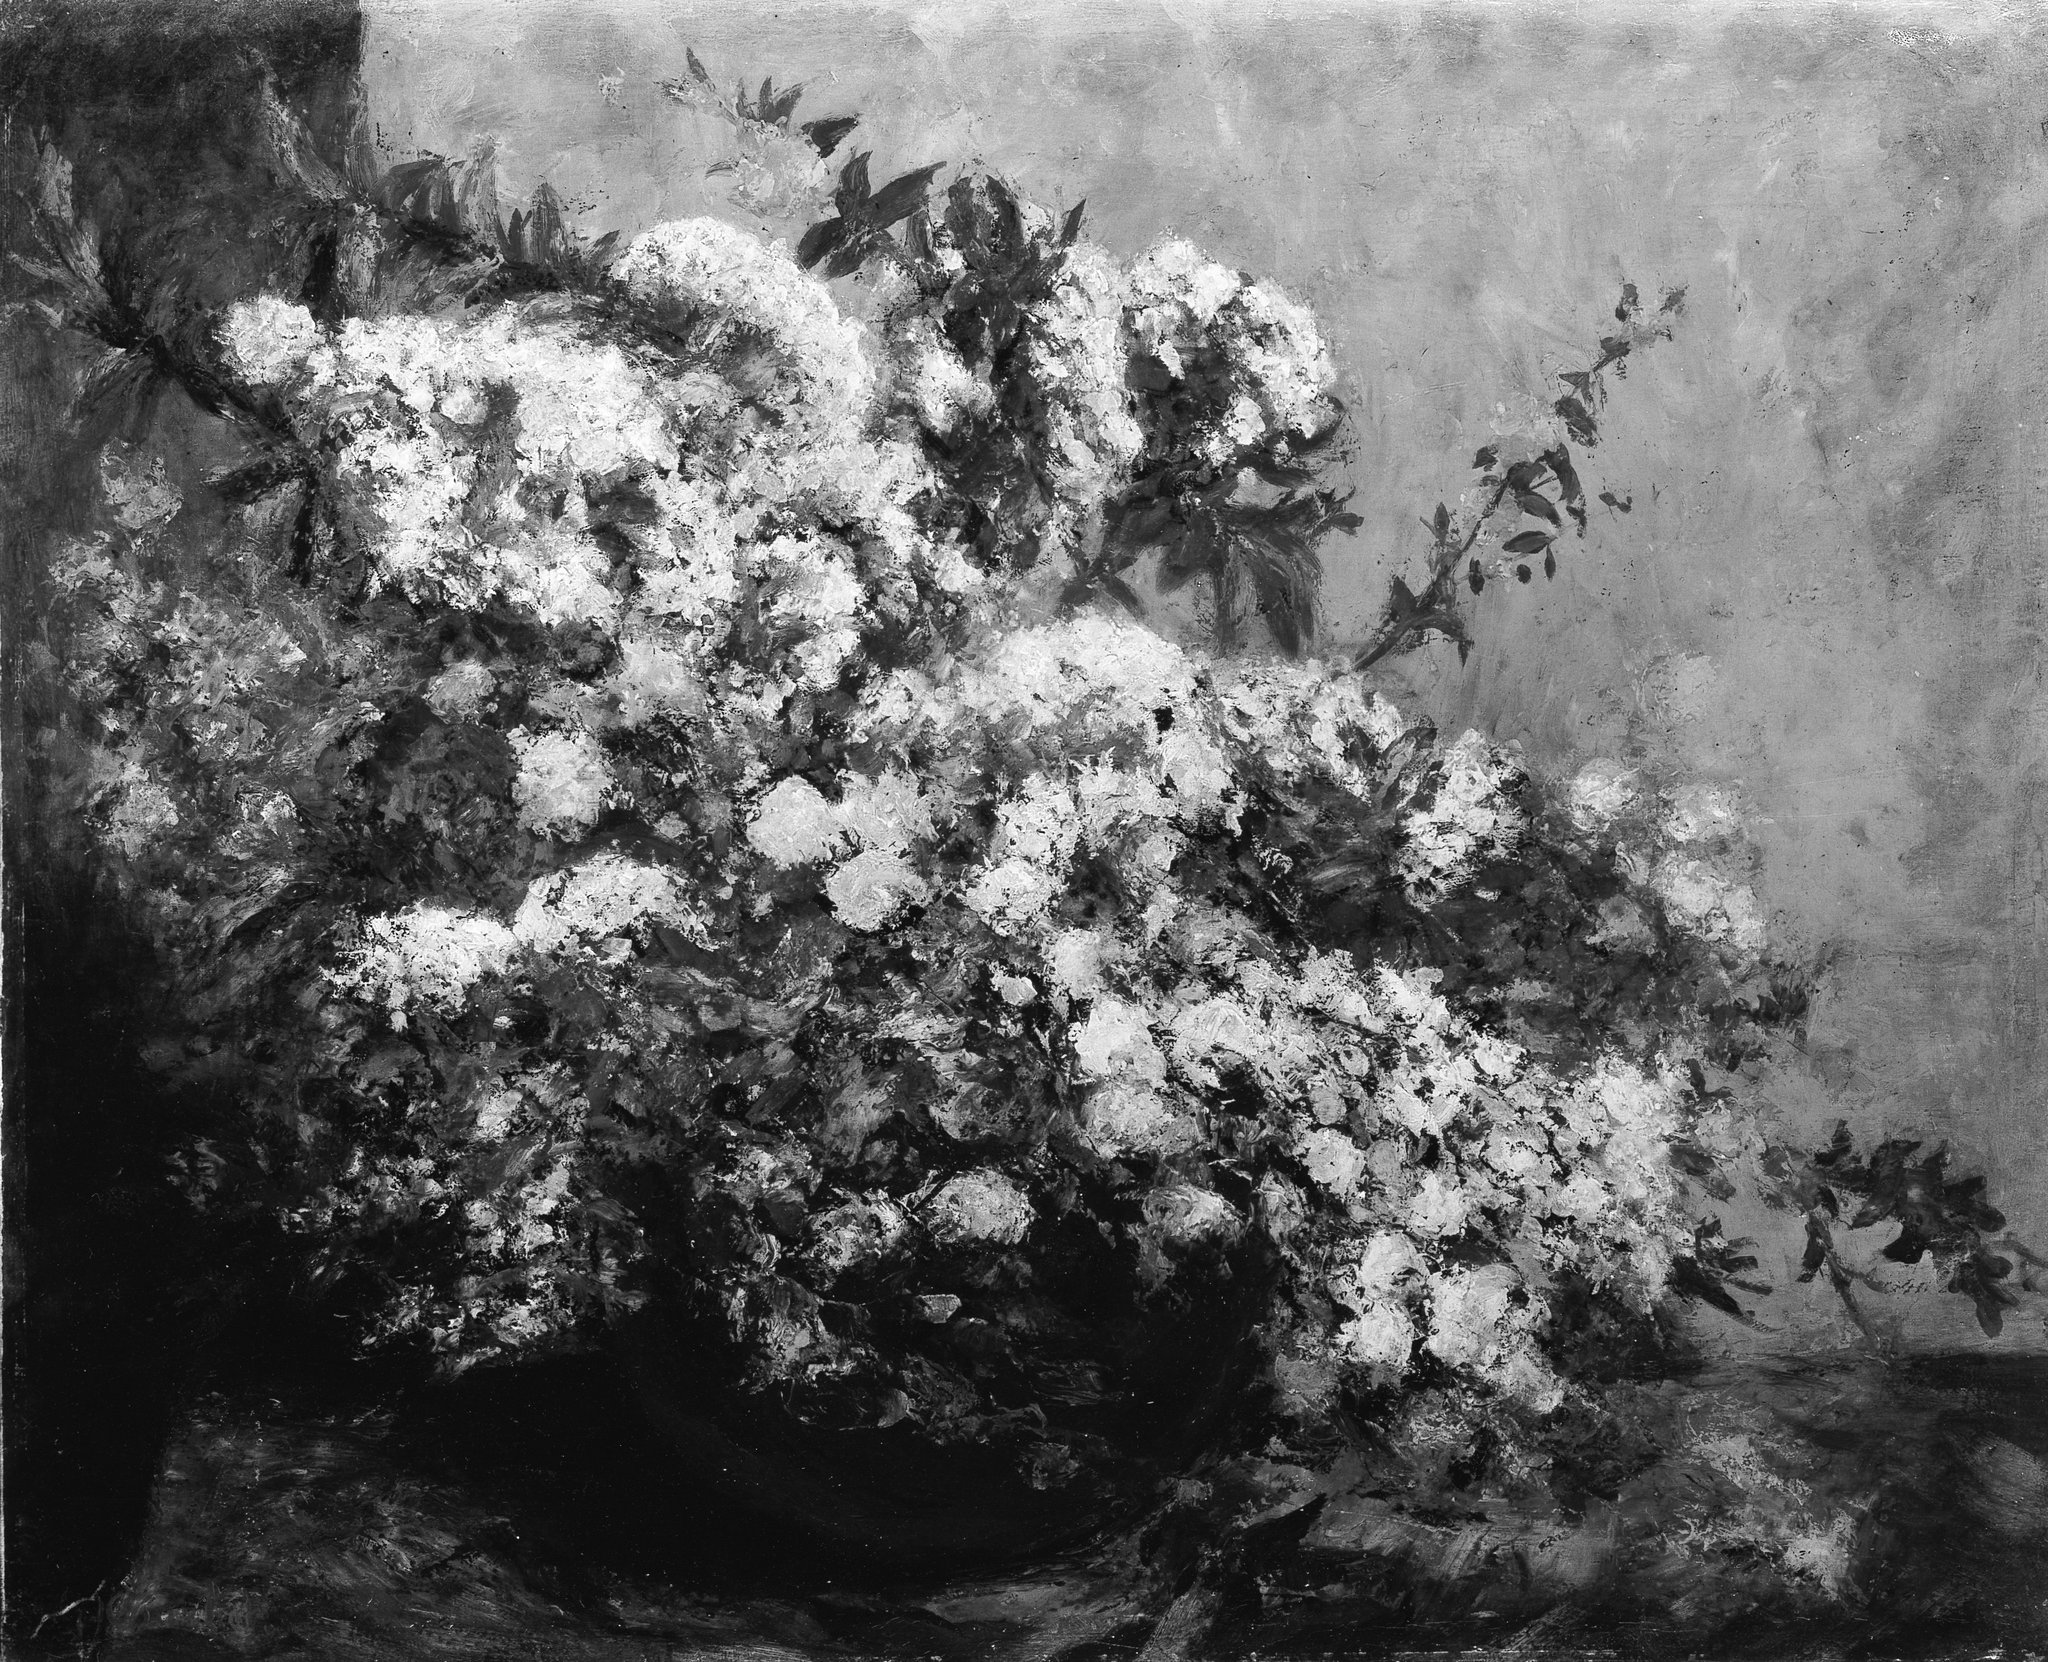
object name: painting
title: Spring Flowers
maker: gustave courbet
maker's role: artist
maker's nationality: french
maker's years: 1819-1877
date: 1855-1860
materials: canvas, oil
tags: flowers,still life